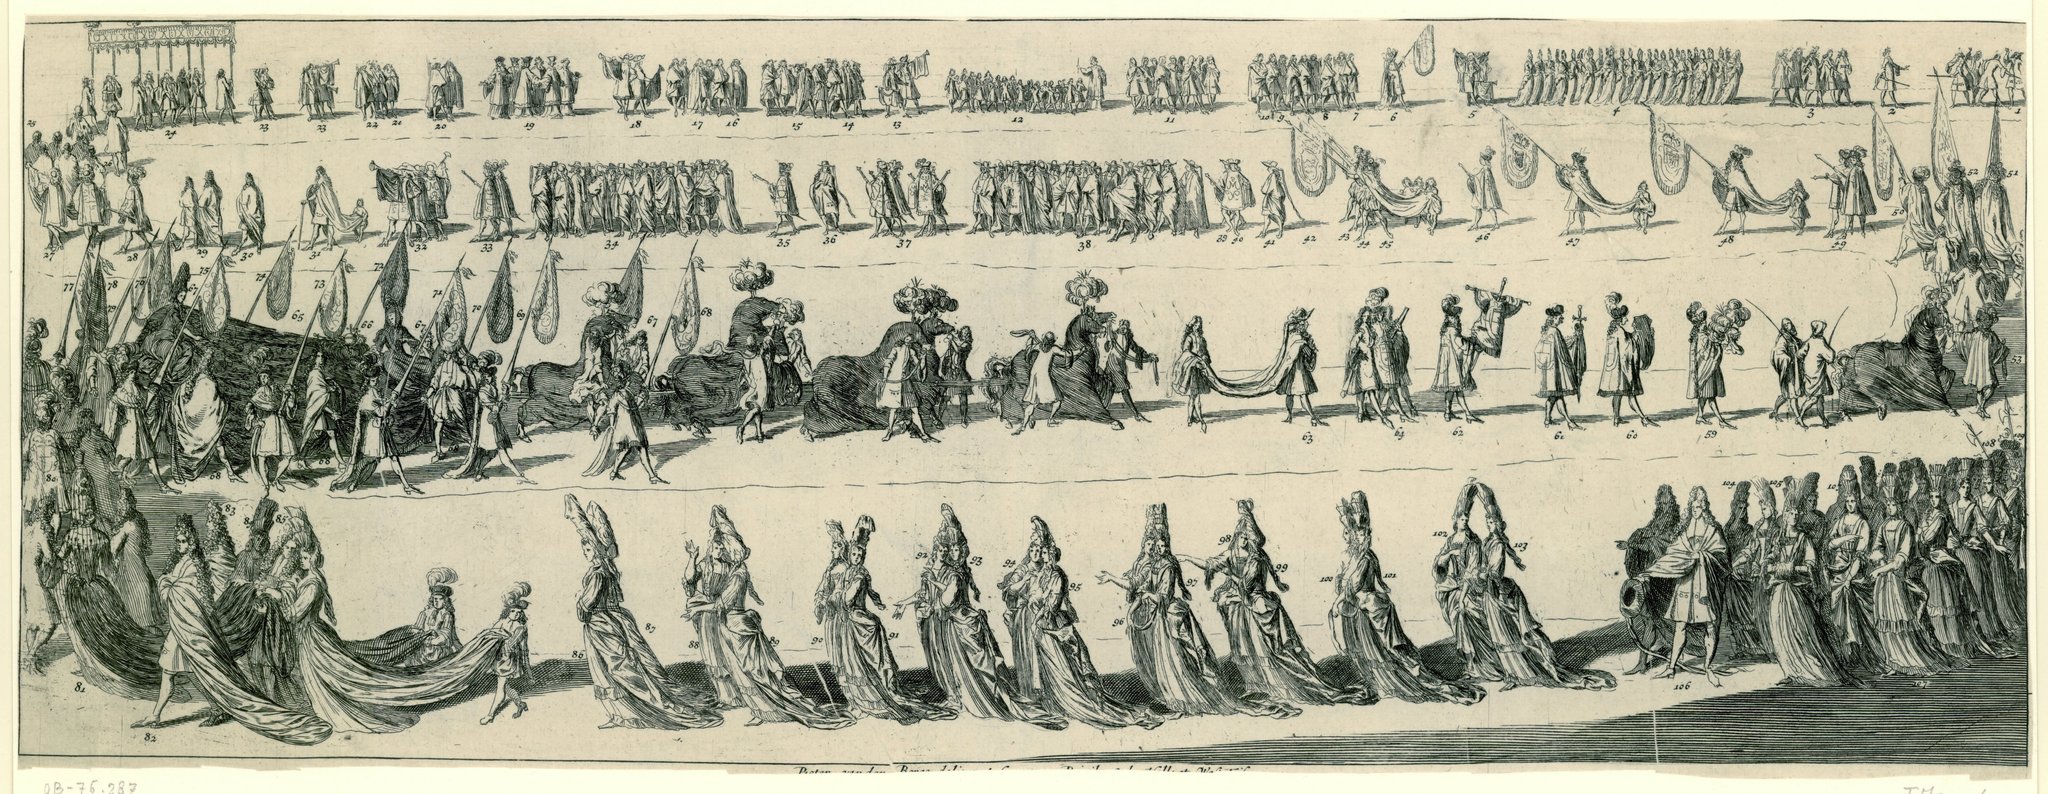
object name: print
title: Begrafenisstoet van Maria Stuart, 1695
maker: pieter van den berge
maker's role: draughtsman, print maker, printer, publisher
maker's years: 1659-1737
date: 1695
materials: paper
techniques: engraving, etching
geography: amsterdam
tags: london, maria ii stuart (koningin van engeland, schotland en ierland), cortege, funeral procession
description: Lijkstatie van de overleden koningin Maria II Stuart, gehouden in Londen op 5 maart 1695. Stoet slingert zich in vier rijen. De legenda bij de voorstelling ontbreekt. De prent maakt onderdeel uit van een groep van drie prenten over de dood van Maria Stuart, geëtst en uitgegeven door Pieter van den Berge in 1695.